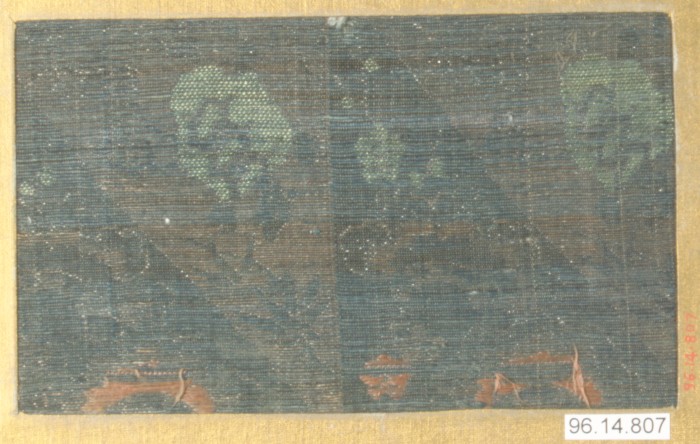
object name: piece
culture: japanese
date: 1701-1900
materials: silk